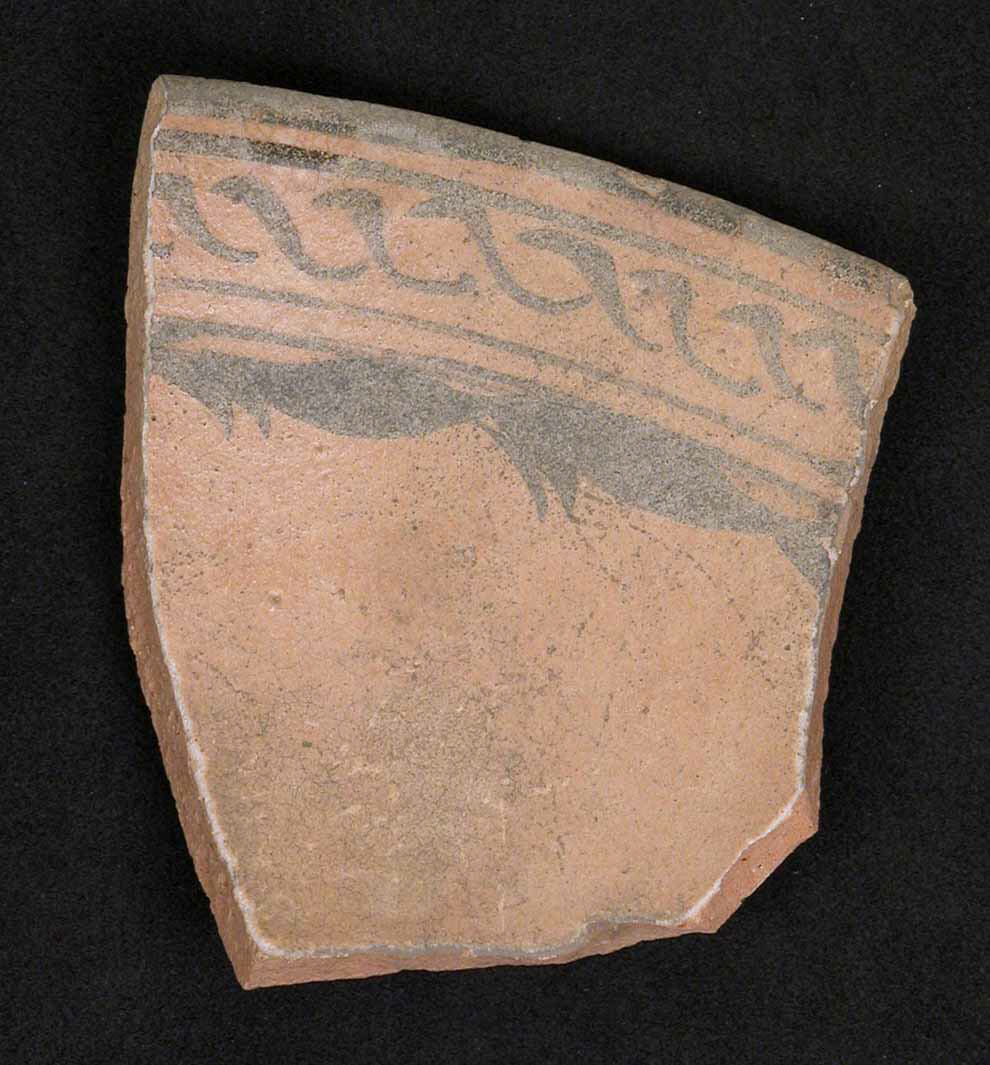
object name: fragment of a bowl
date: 1501-1600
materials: earthenware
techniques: glazing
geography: iran